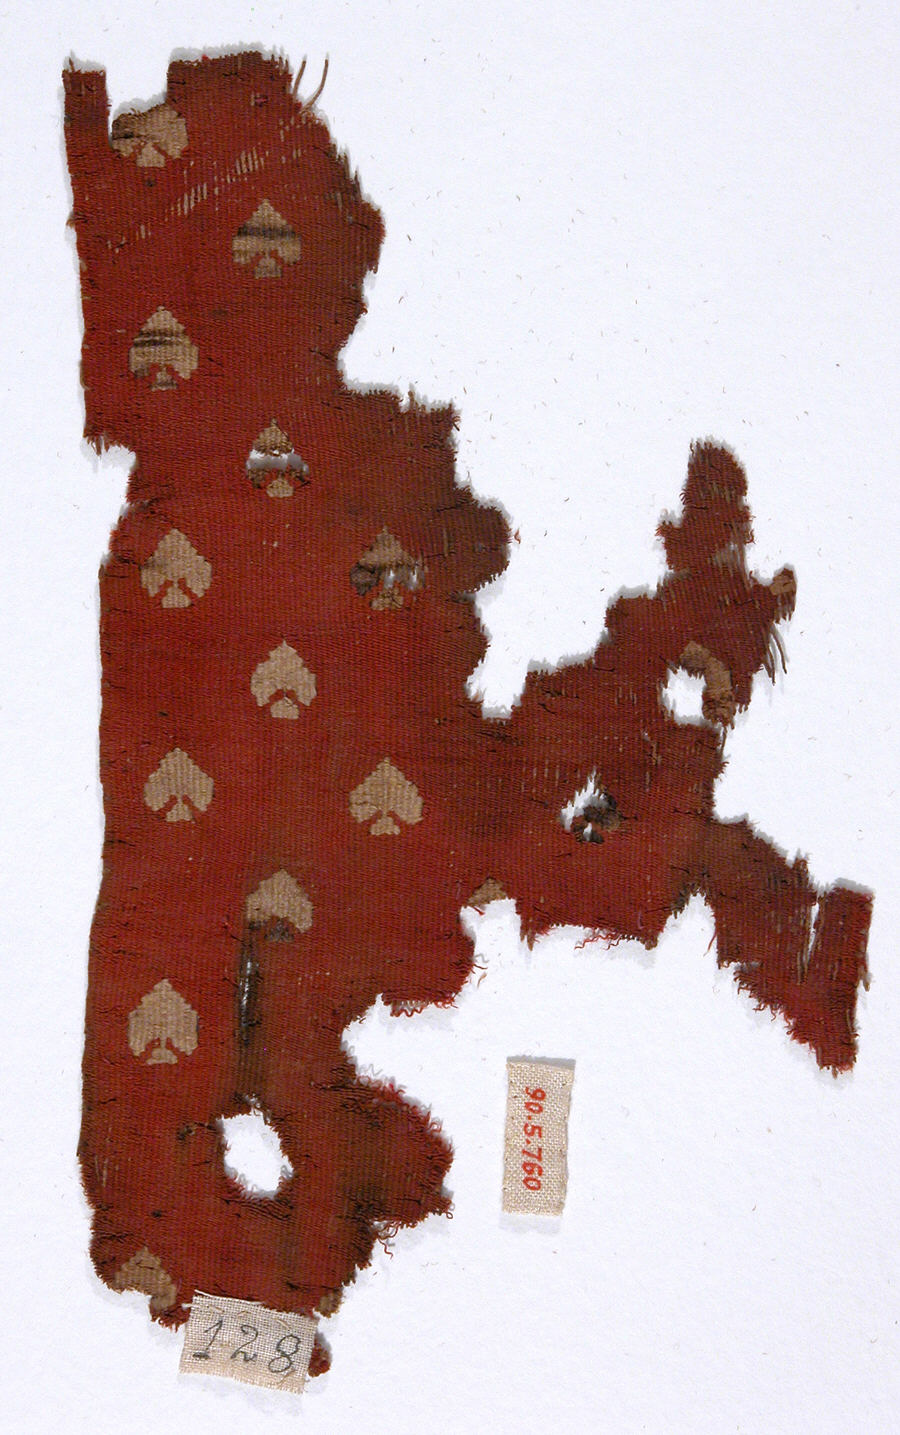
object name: textile fragment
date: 401-500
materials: linen, wool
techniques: weave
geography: egypt